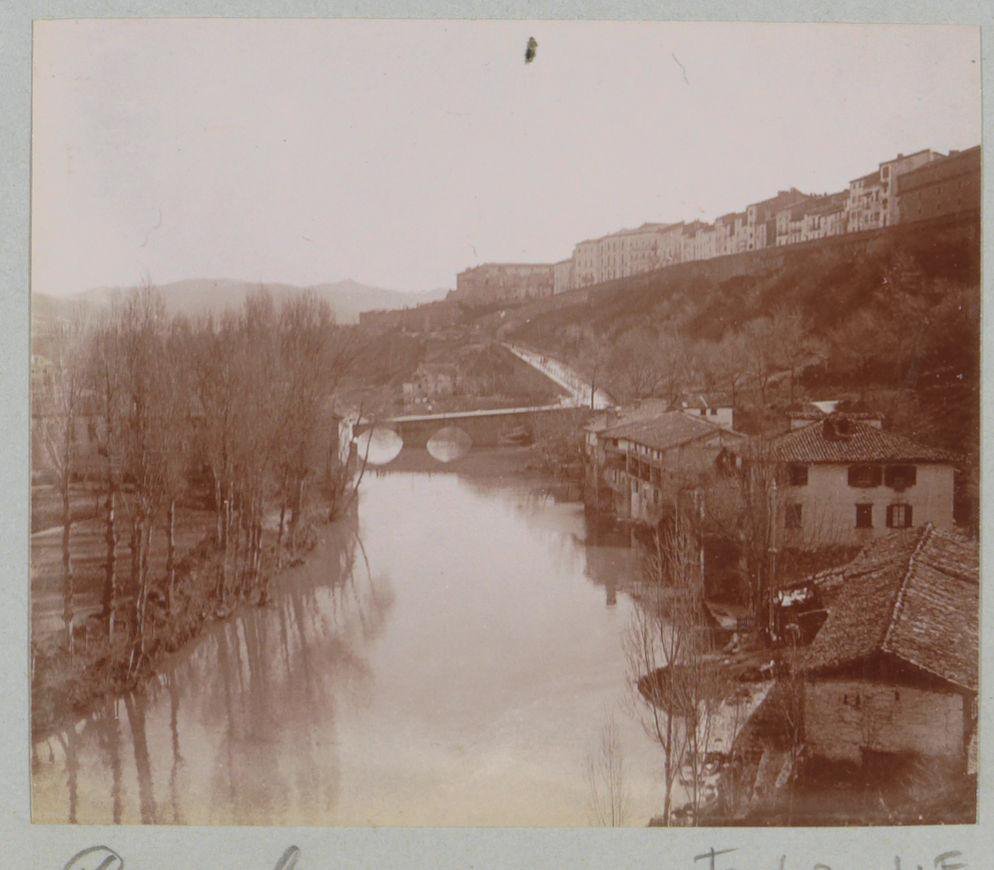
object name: photograph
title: Gezicht op Pamplona aan de Arga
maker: delizy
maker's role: manufacturer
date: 1904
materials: paper, photographic support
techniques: gelatin silver print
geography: pamplona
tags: river bank, bridge in city across river, canal, etc., prospect of city, town panorama, silhouette of city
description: Onderdeel van Fotoalbum van een Franse amateurfotograaf met opnames van uitstapjes in Frankrijk, Spanje, België, Luxemburg en Nederland, de eerste automobielen en autoraces.